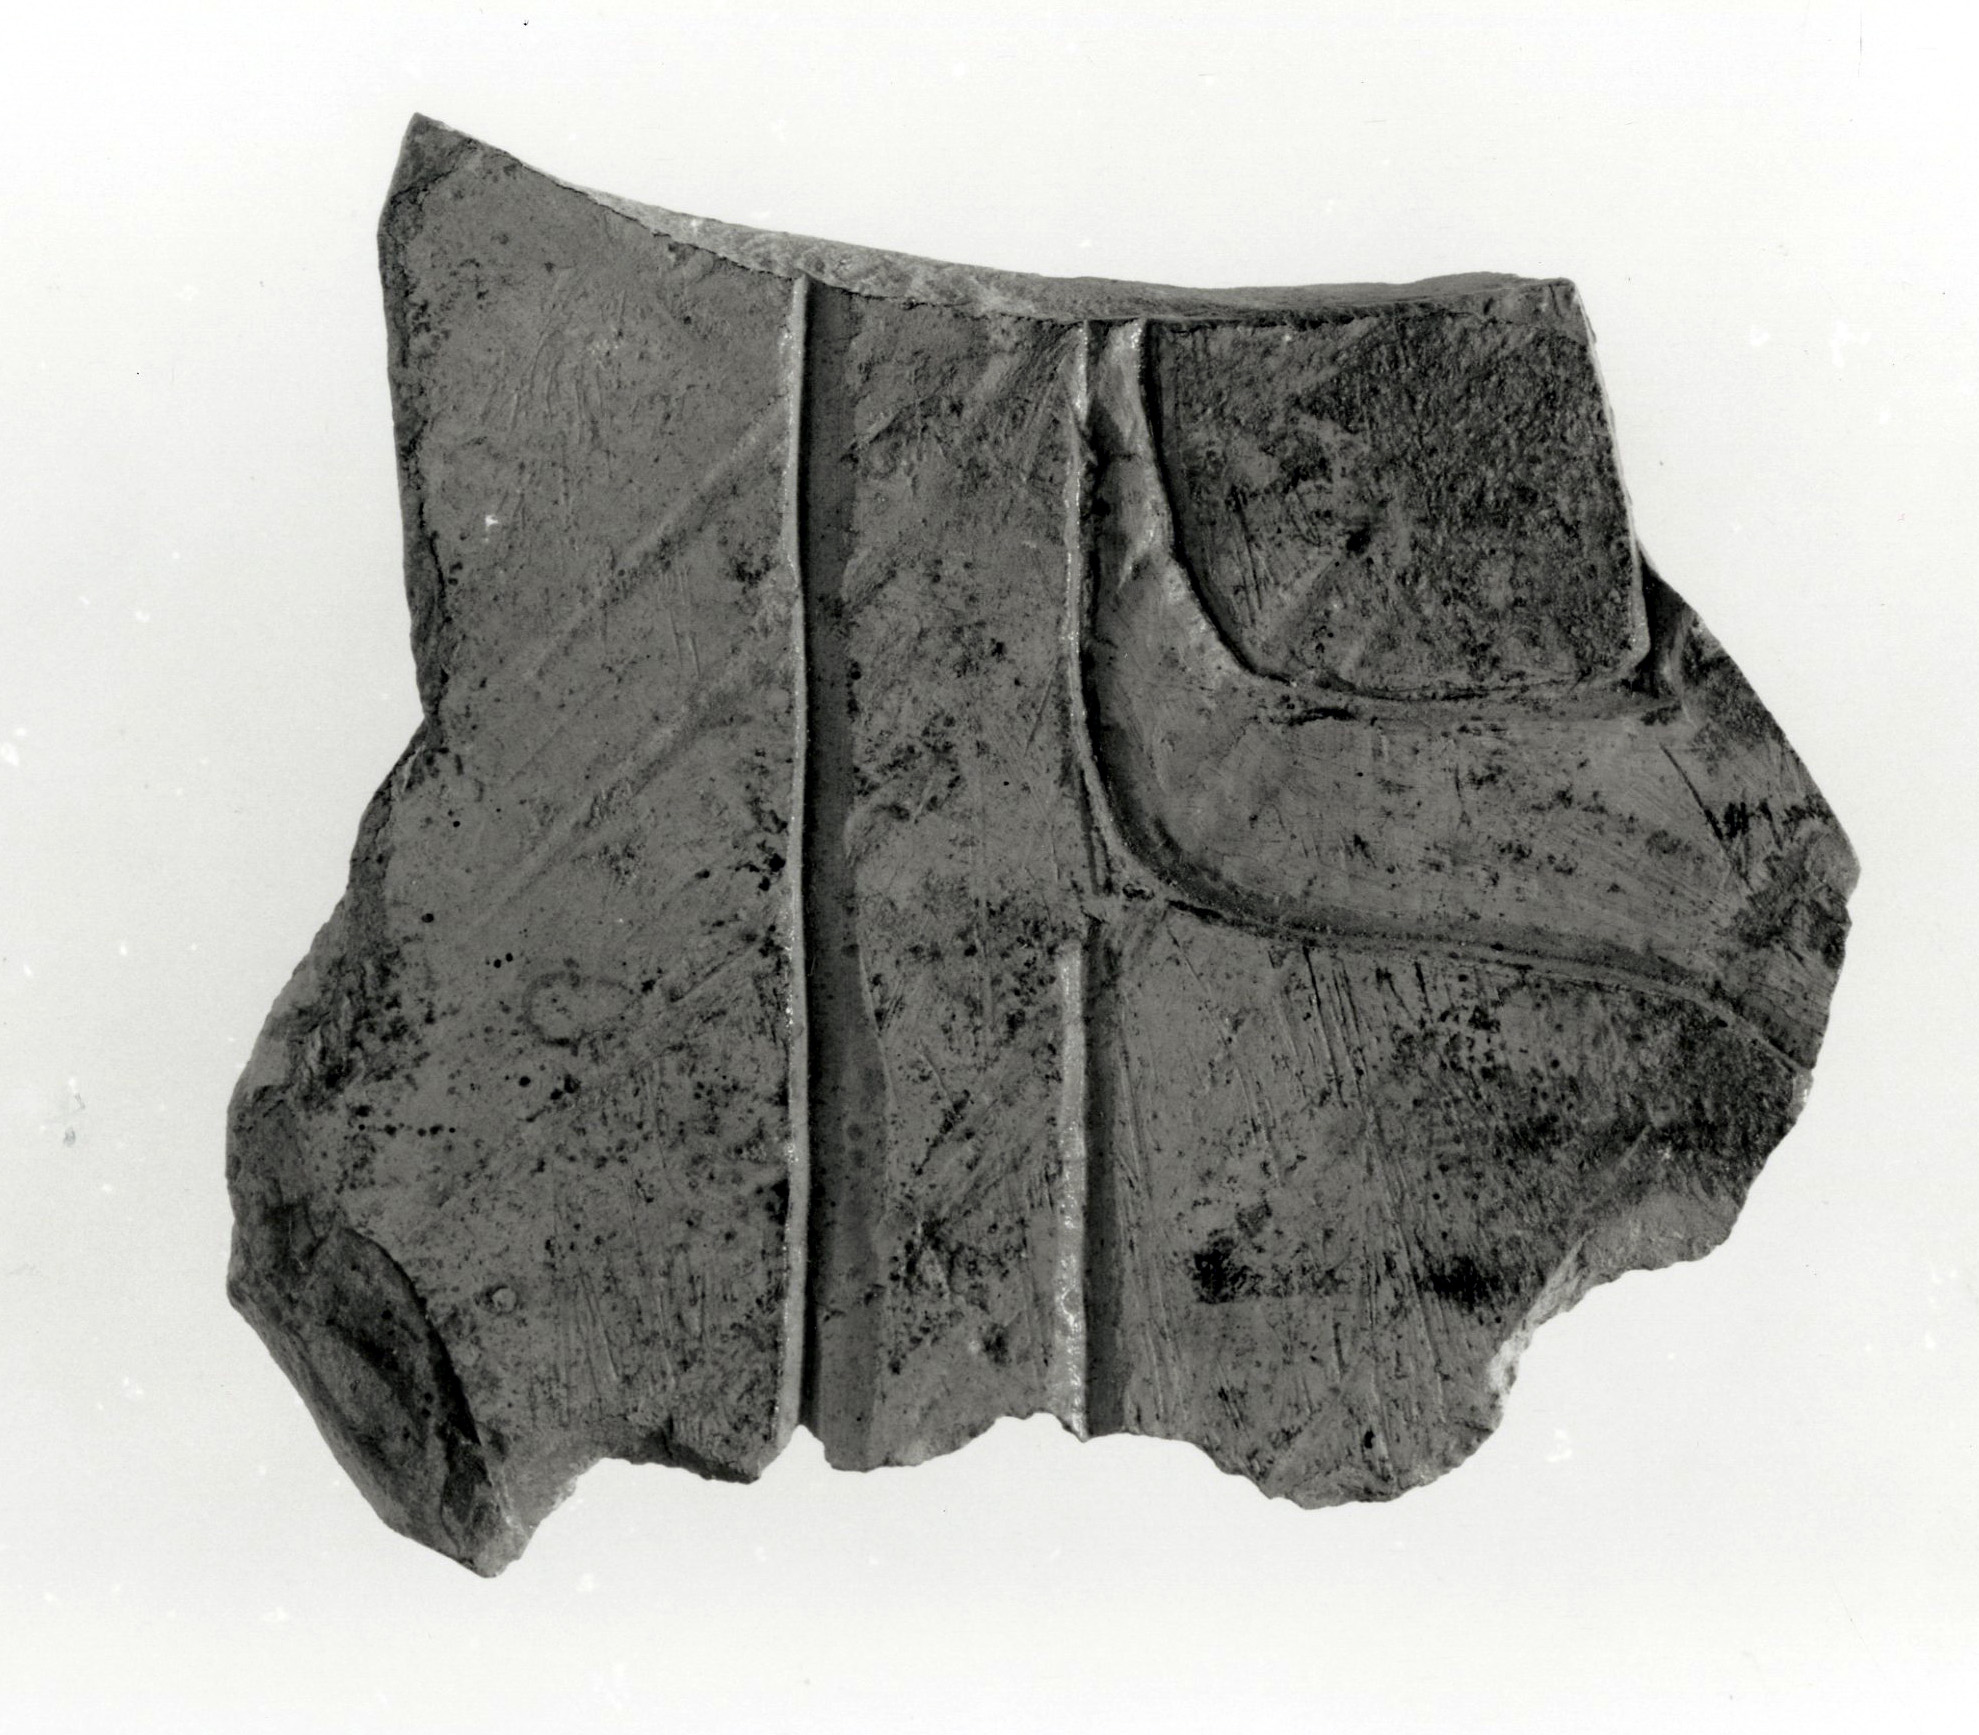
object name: relief, tomb of nespekashuty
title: Sunk relief fragment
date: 664-610 BCE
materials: limestone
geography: egypt